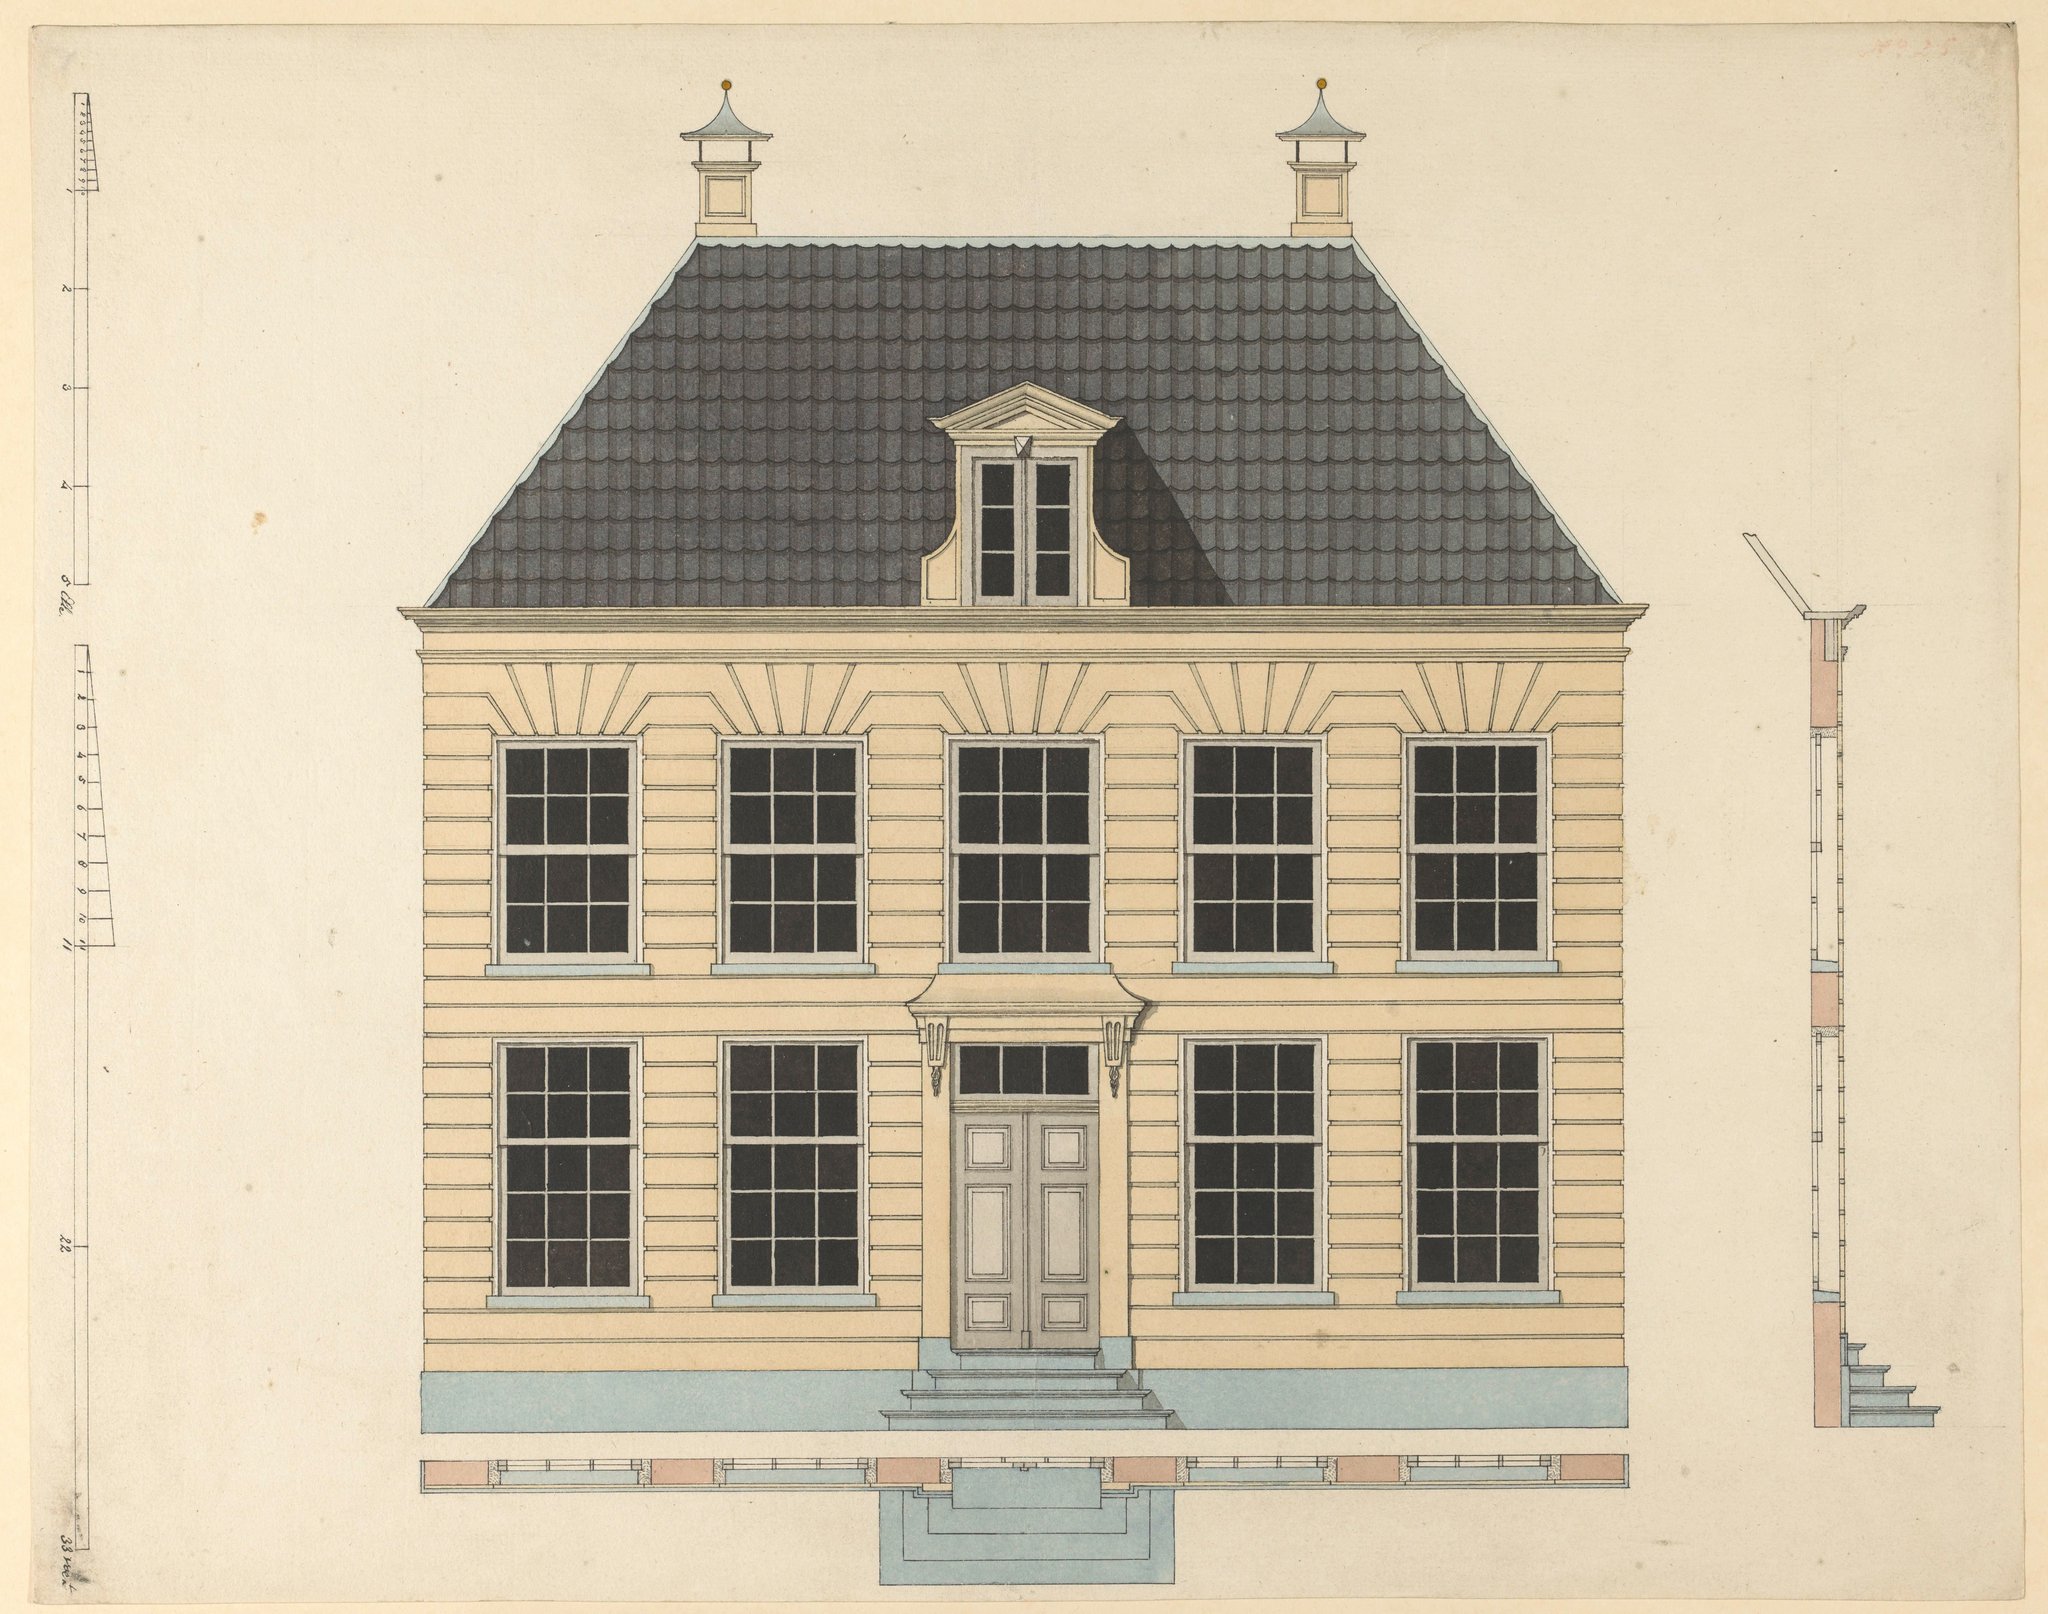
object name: drawing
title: Ontwerp voor een voorgevel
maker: wybrand tollenaar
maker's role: draughtsman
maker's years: 1778-1852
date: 1788-1852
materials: ink, paper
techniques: brush, pen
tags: façade (of house or building), civic architecture; edifices; dwellings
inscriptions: collector's mark: Lugt 2228